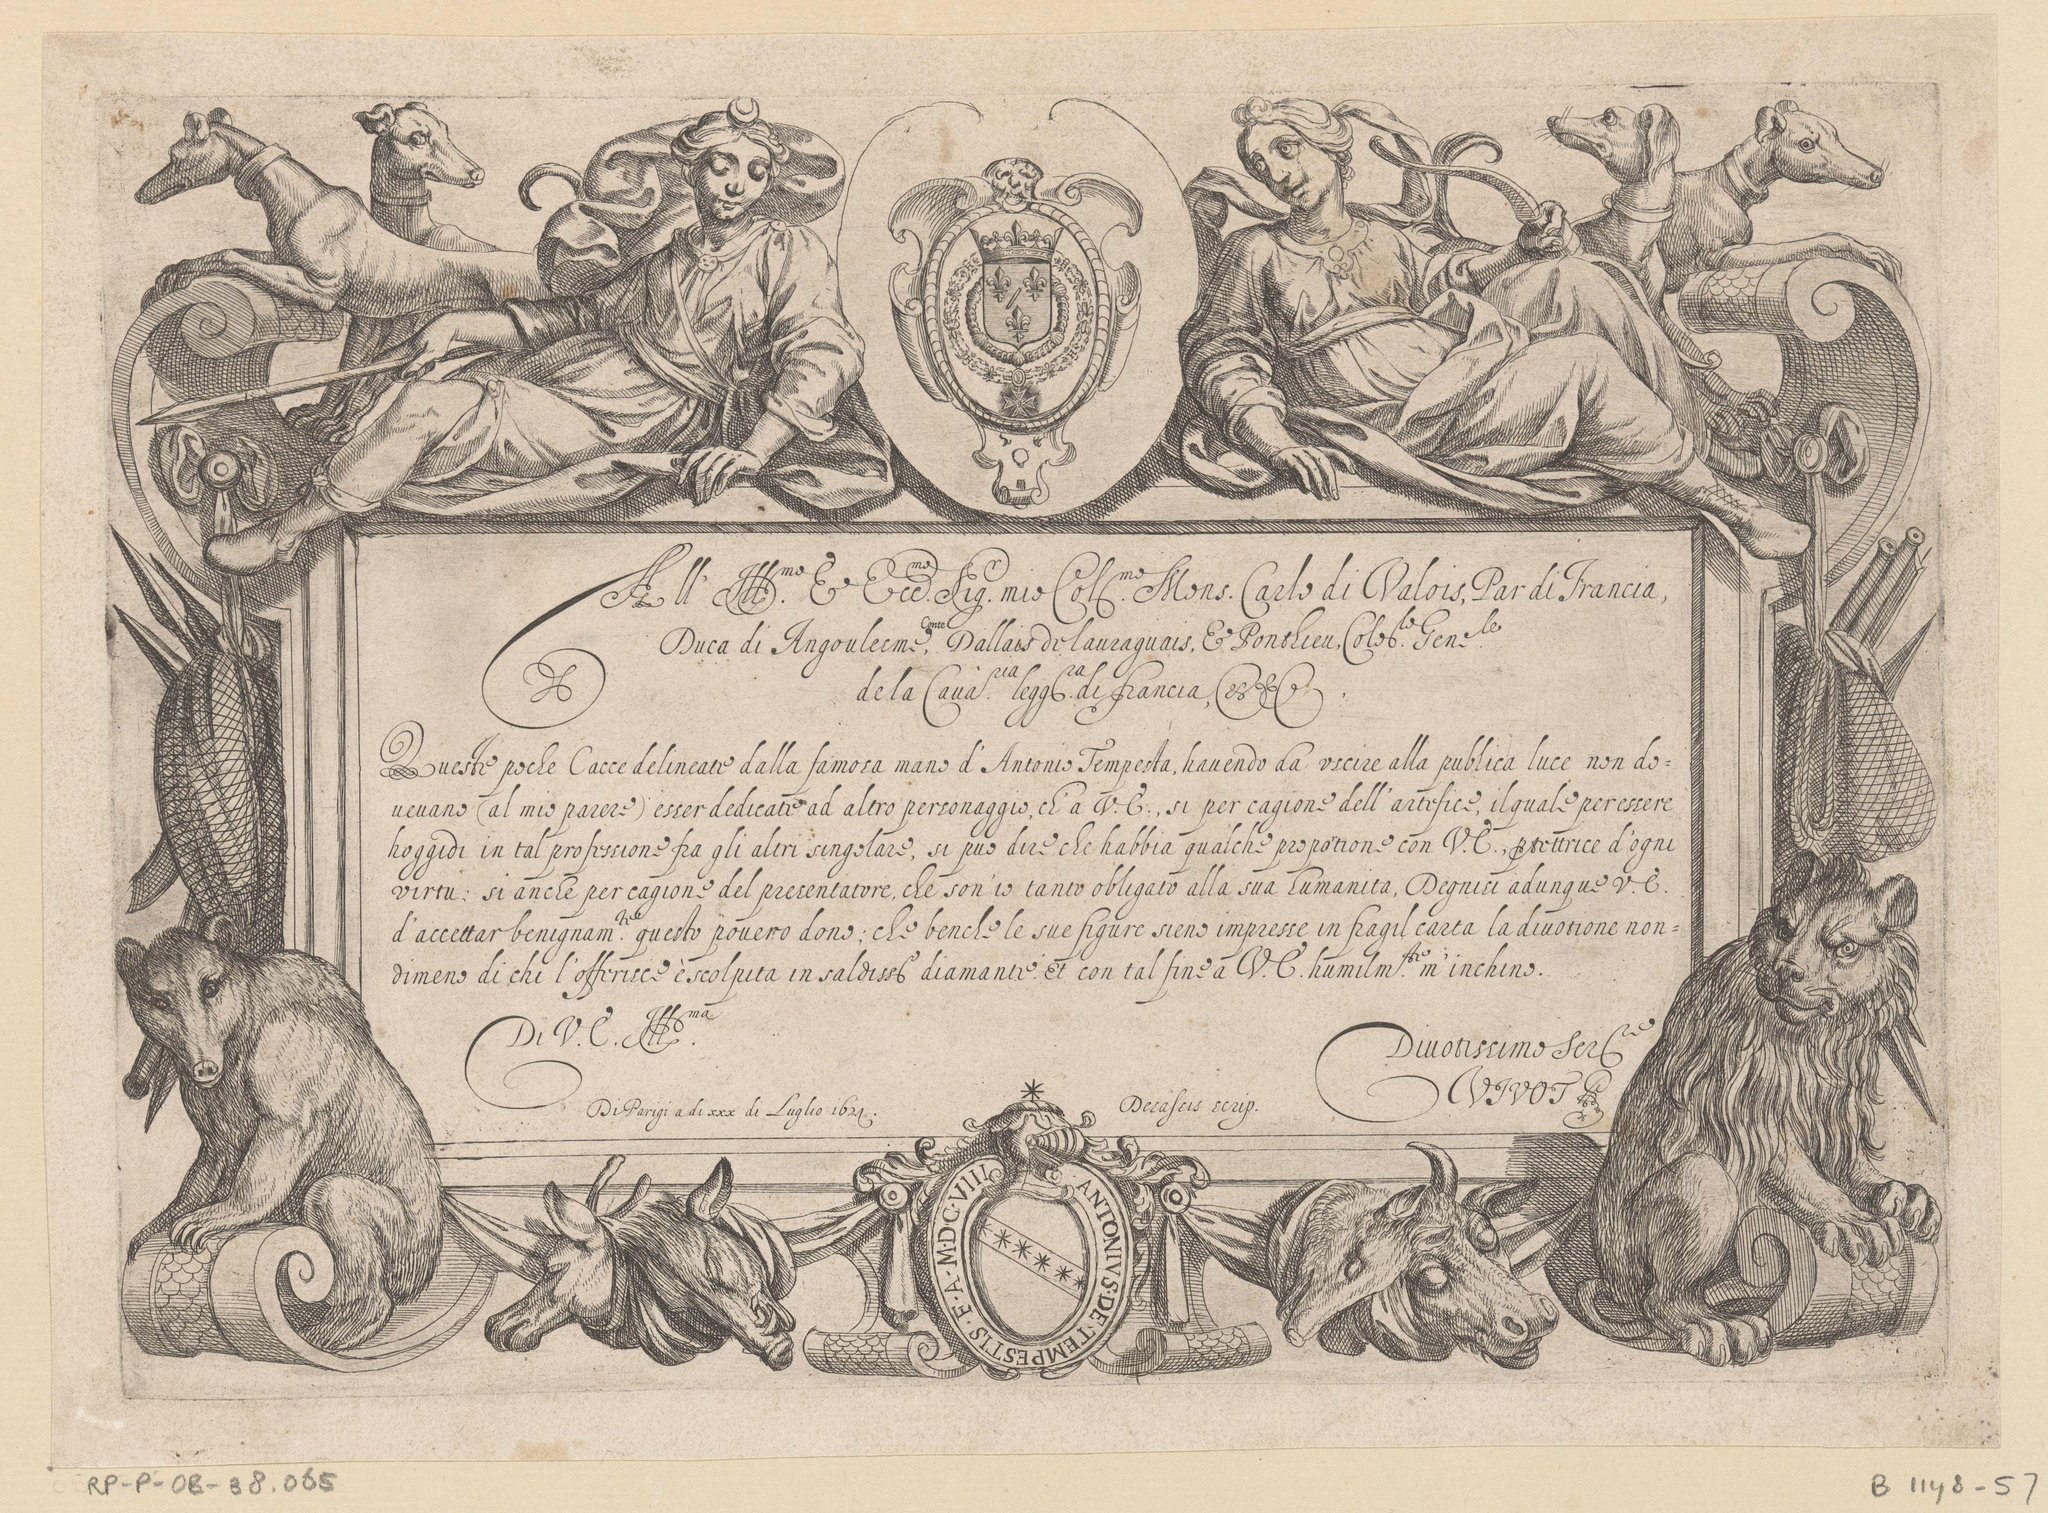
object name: print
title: Jachtscènes (deel 7)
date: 1608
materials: paper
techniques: etching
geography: rome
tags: (story of) diana (artemis), hunting dogs, other companions, nymphs of diana, beasts of prey, predatory animals: bear, ornament ~ cartouche, beasts of prey, predatory animals: lion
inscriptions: collector's mark: Lugt 240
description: Opdracht bij een reeks van acht prenten met jachtscènes.